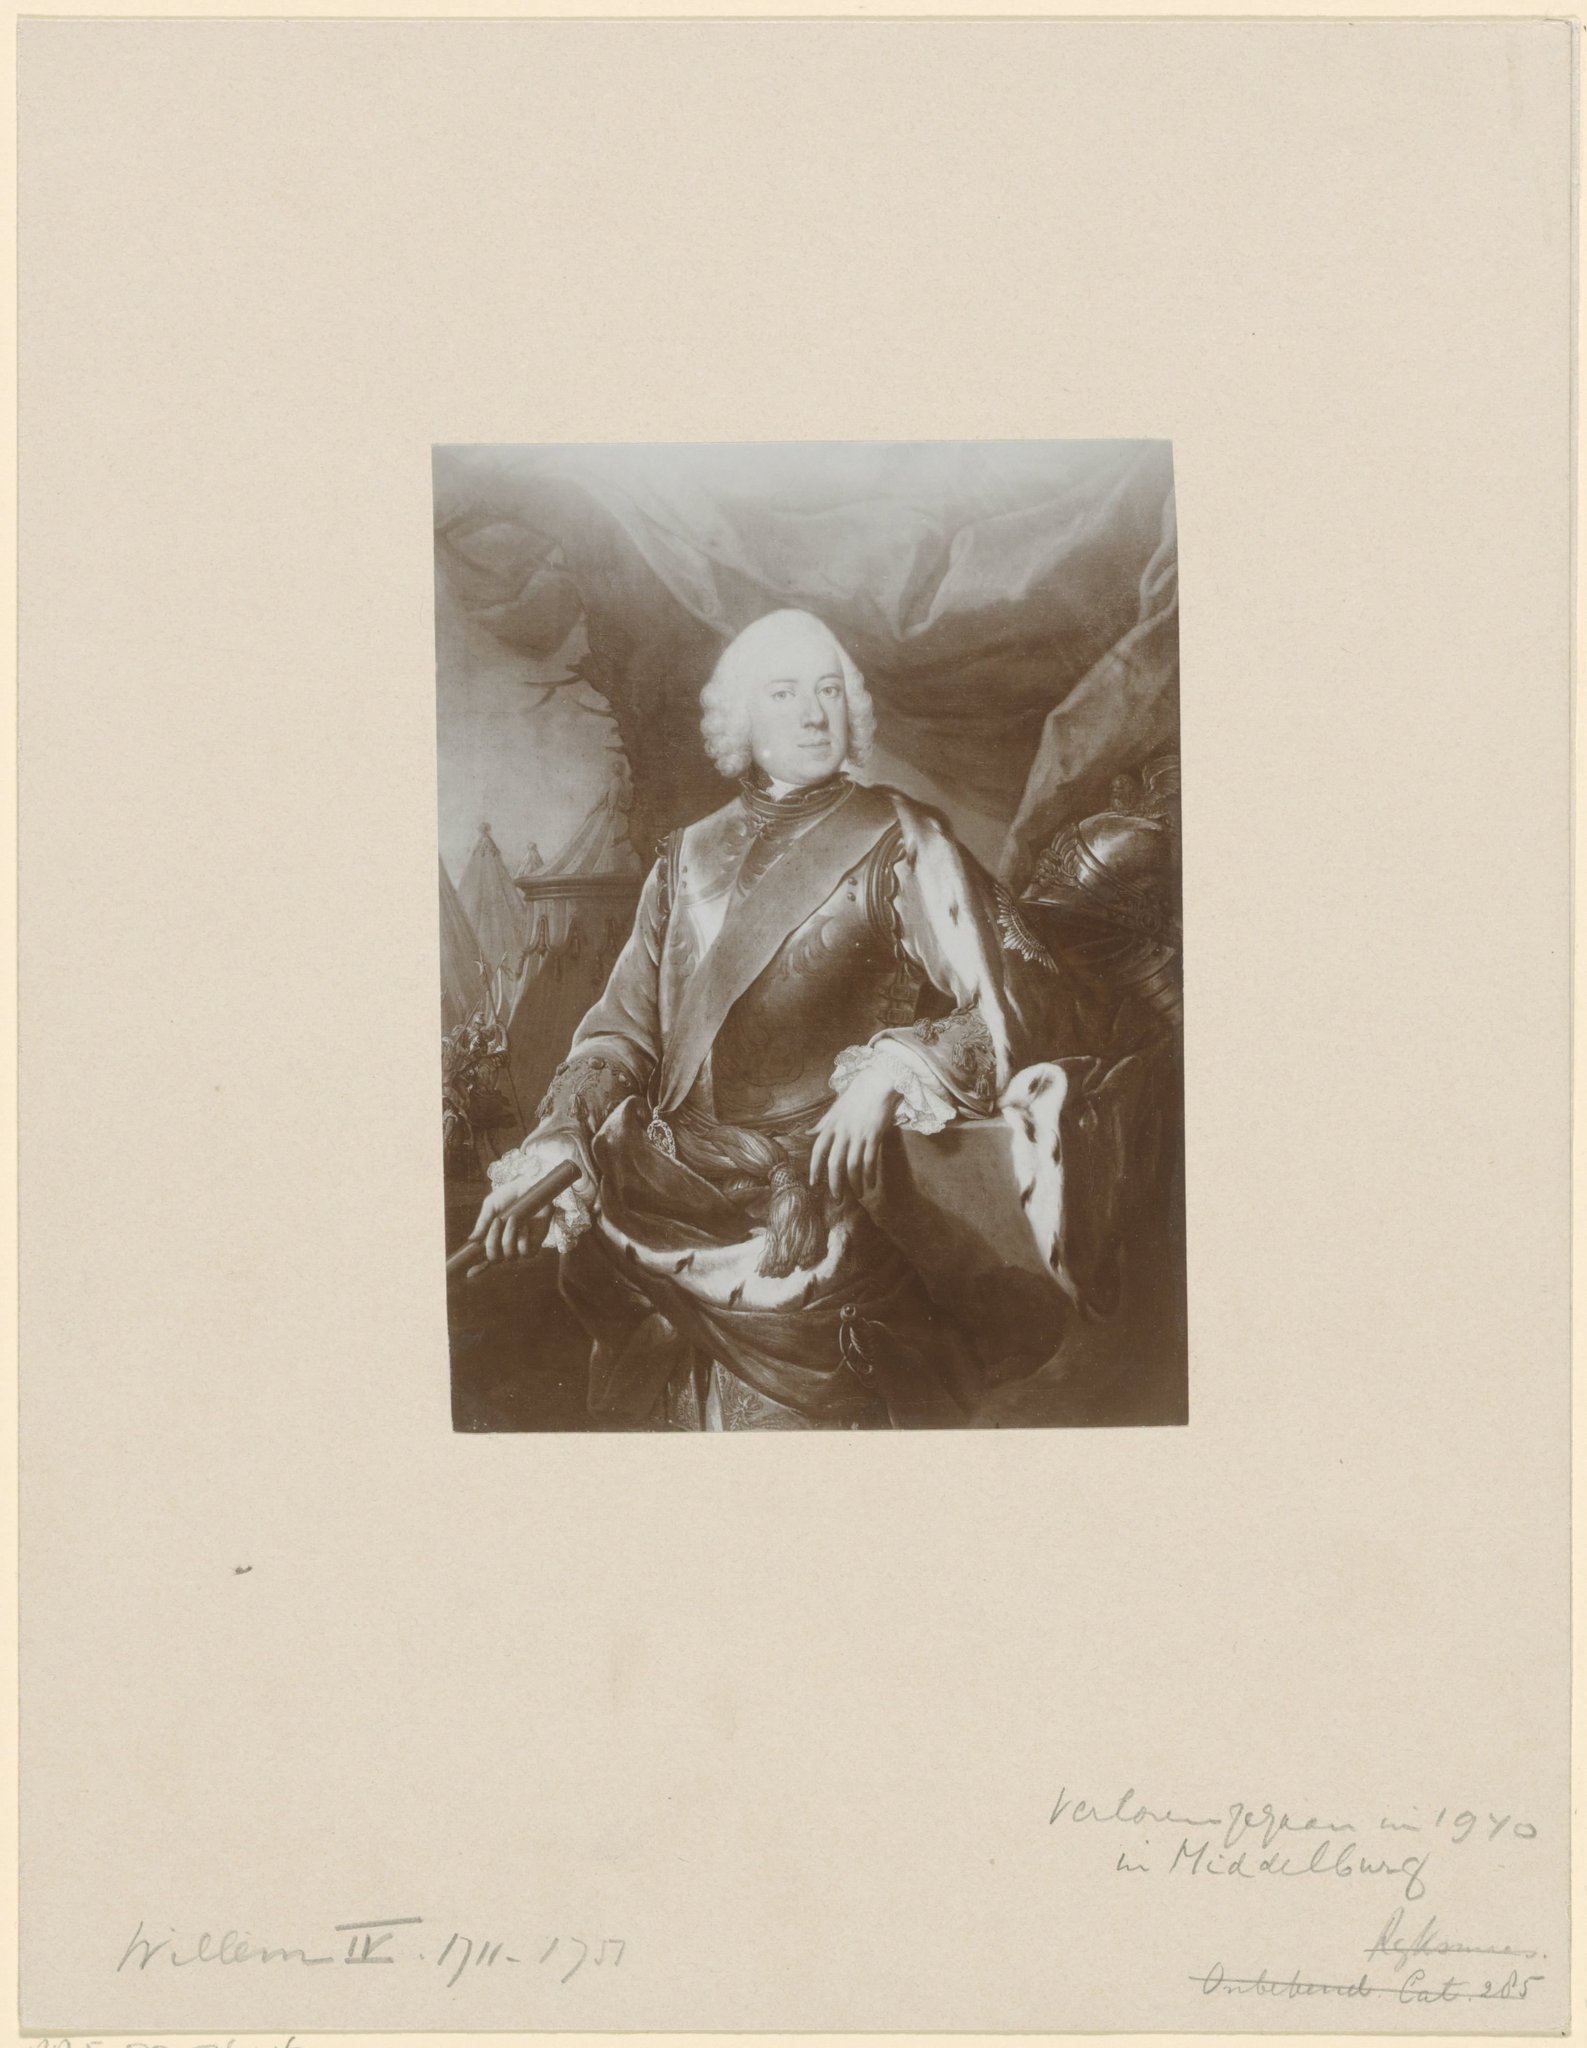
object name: photograph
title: Portret van Willem IV, prins van Oranje-Nassau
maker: Anonymous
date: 1850-1930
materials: photographic support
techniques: photography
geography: netherlands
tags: the hague, willem iv (prins van oranje-nassau)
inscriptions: collector's mark: Lugt 2228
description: De hier vermelde titel verwijst naar de hoogst verkregen titel van de geportretteerde, niet per se naar de titel die de geportretteerde op deze voorstelling draagt.